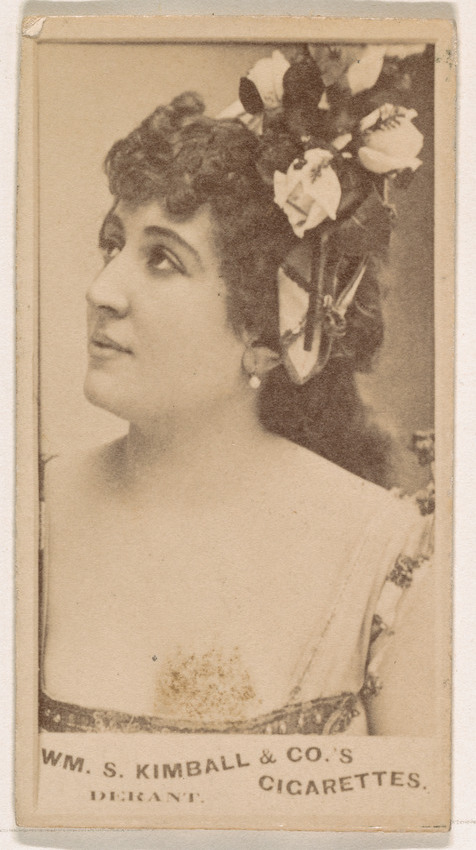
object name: photograph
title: Miss Derant, from the Actresses series (N203) issued by Wm. S. Kimball & Co.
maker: william s. kimball & company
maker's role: publisher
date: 1889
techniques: color lithograph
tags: portraits,women,actresses